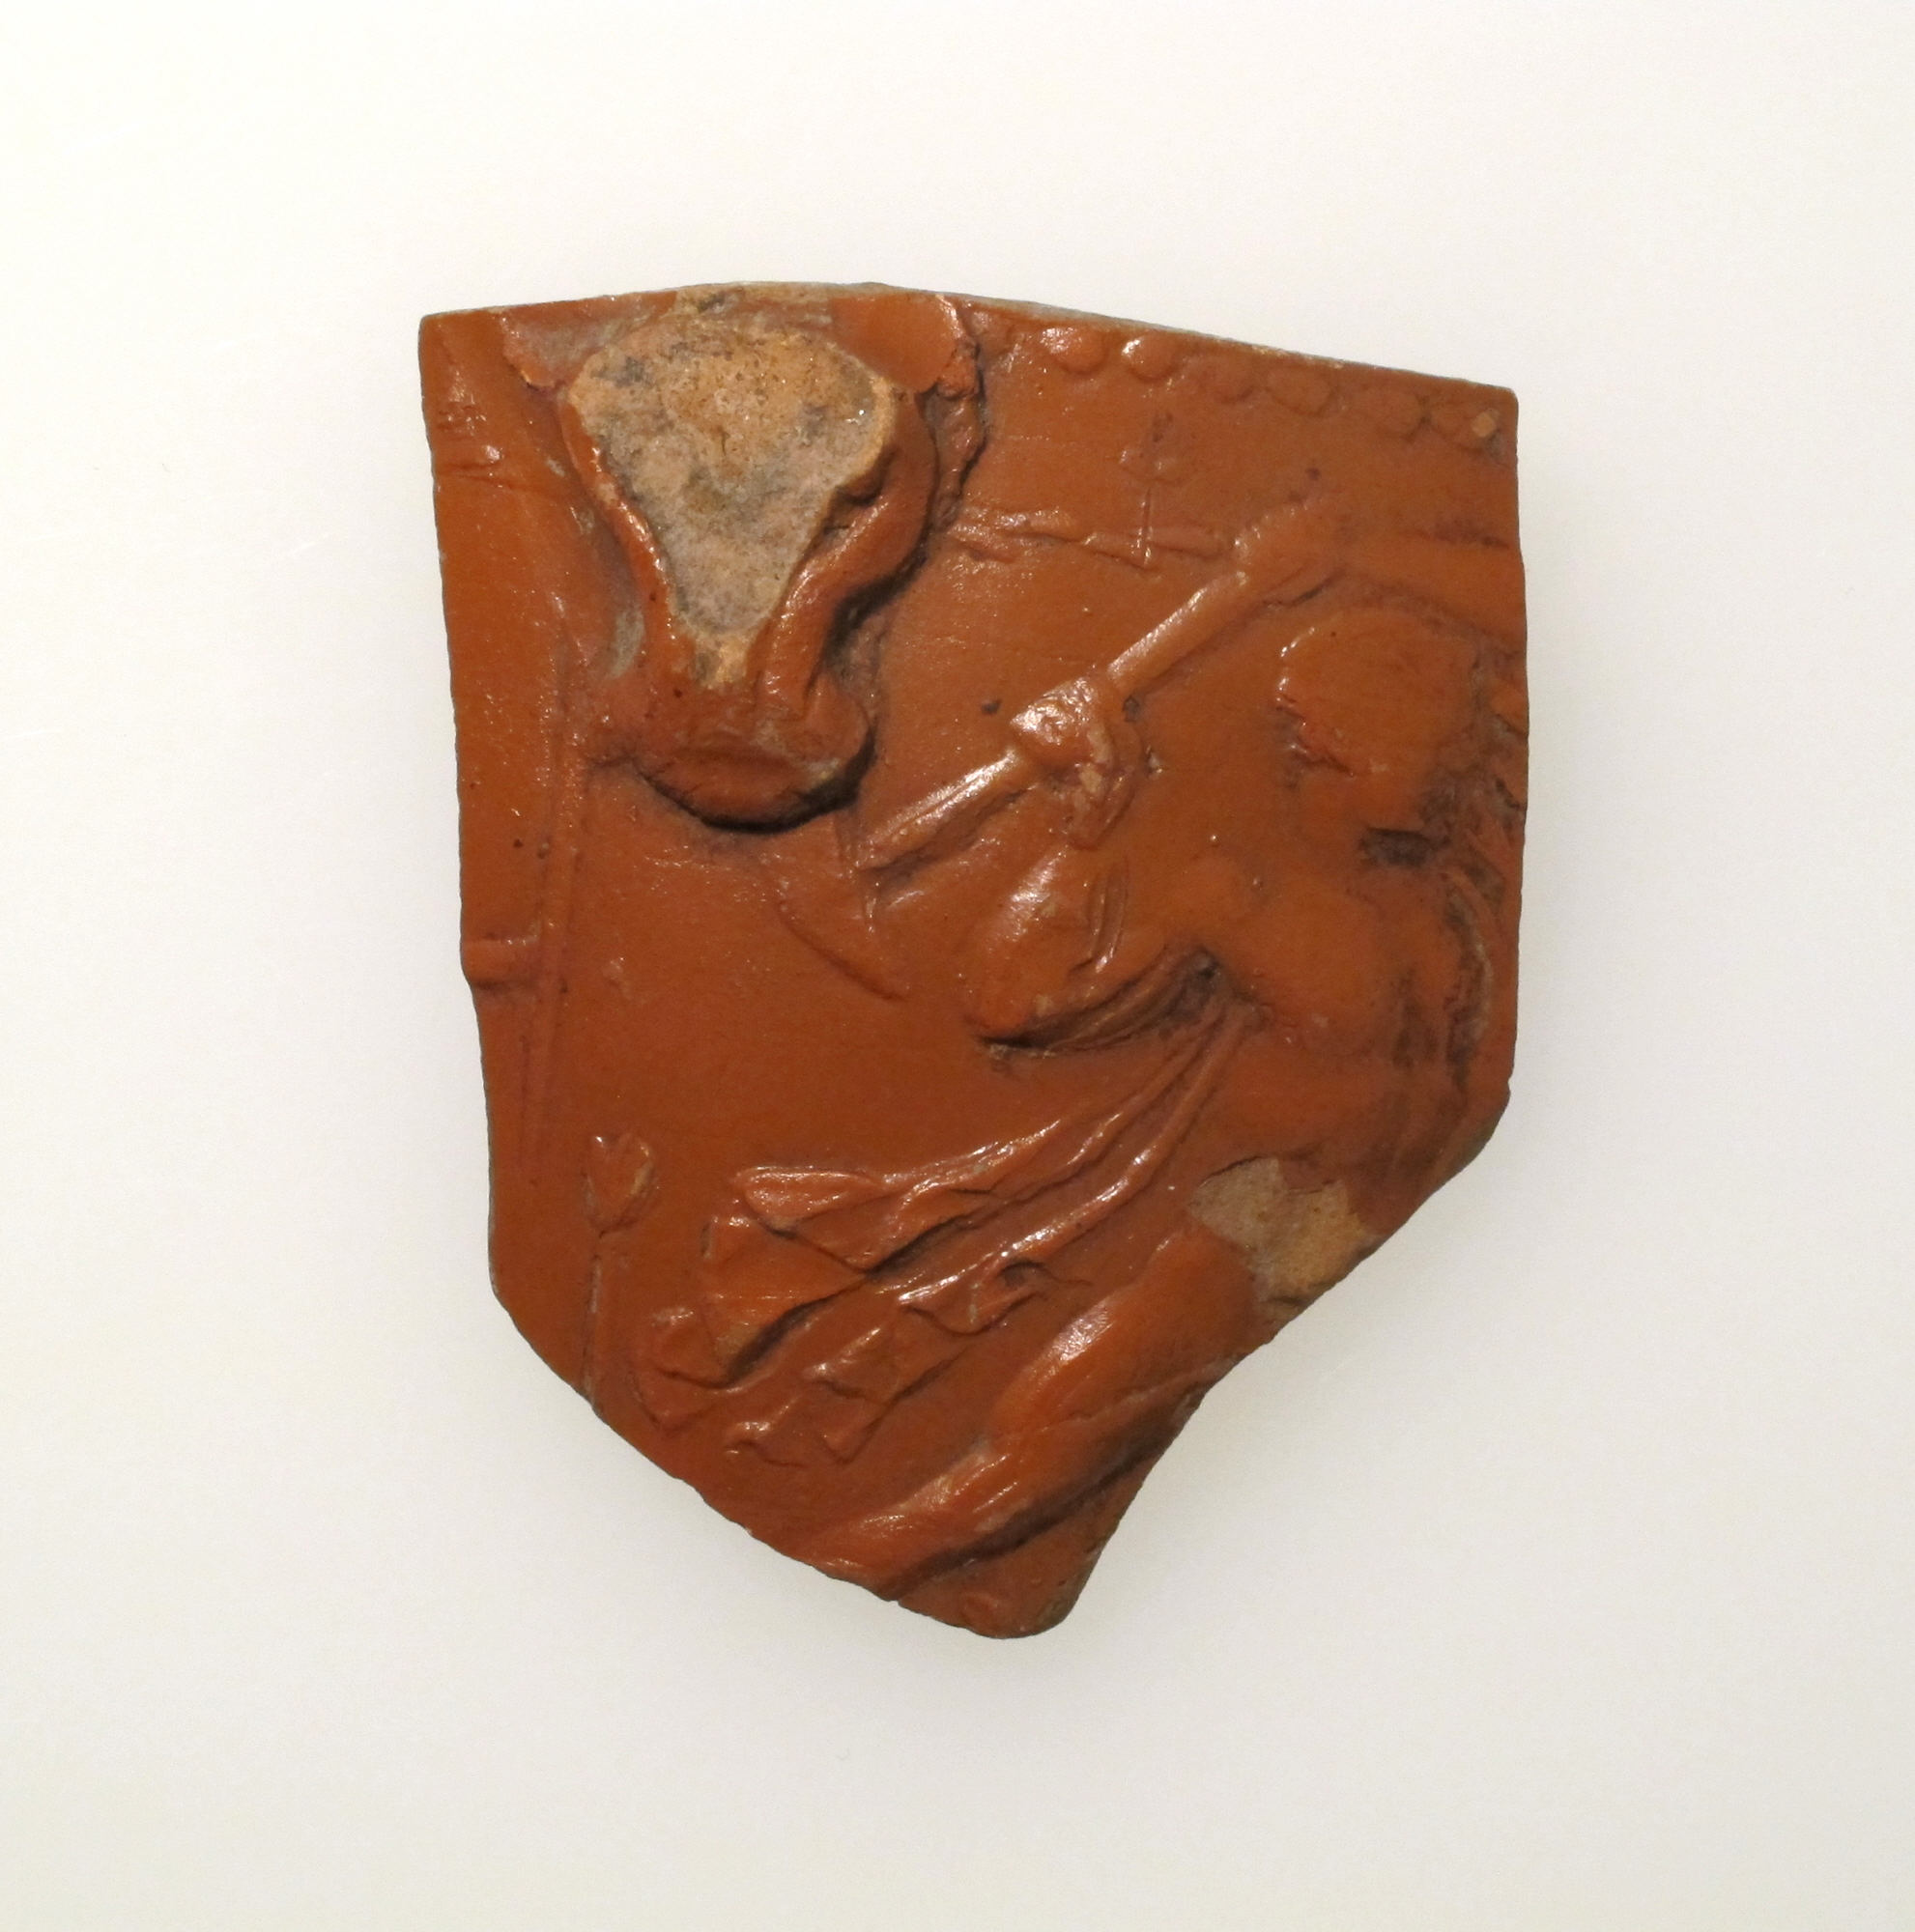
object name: vase fragment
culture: roman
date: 100 BCE-100 CE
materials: terracotta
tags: men